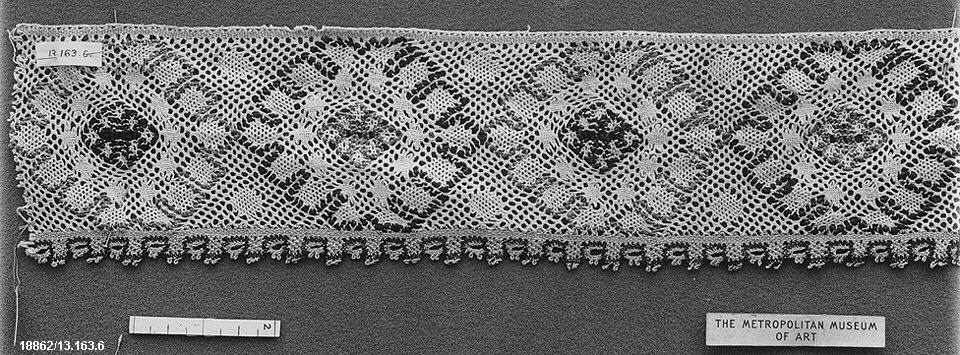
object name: fragment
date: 1701-1800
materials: linen, silk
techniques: lace